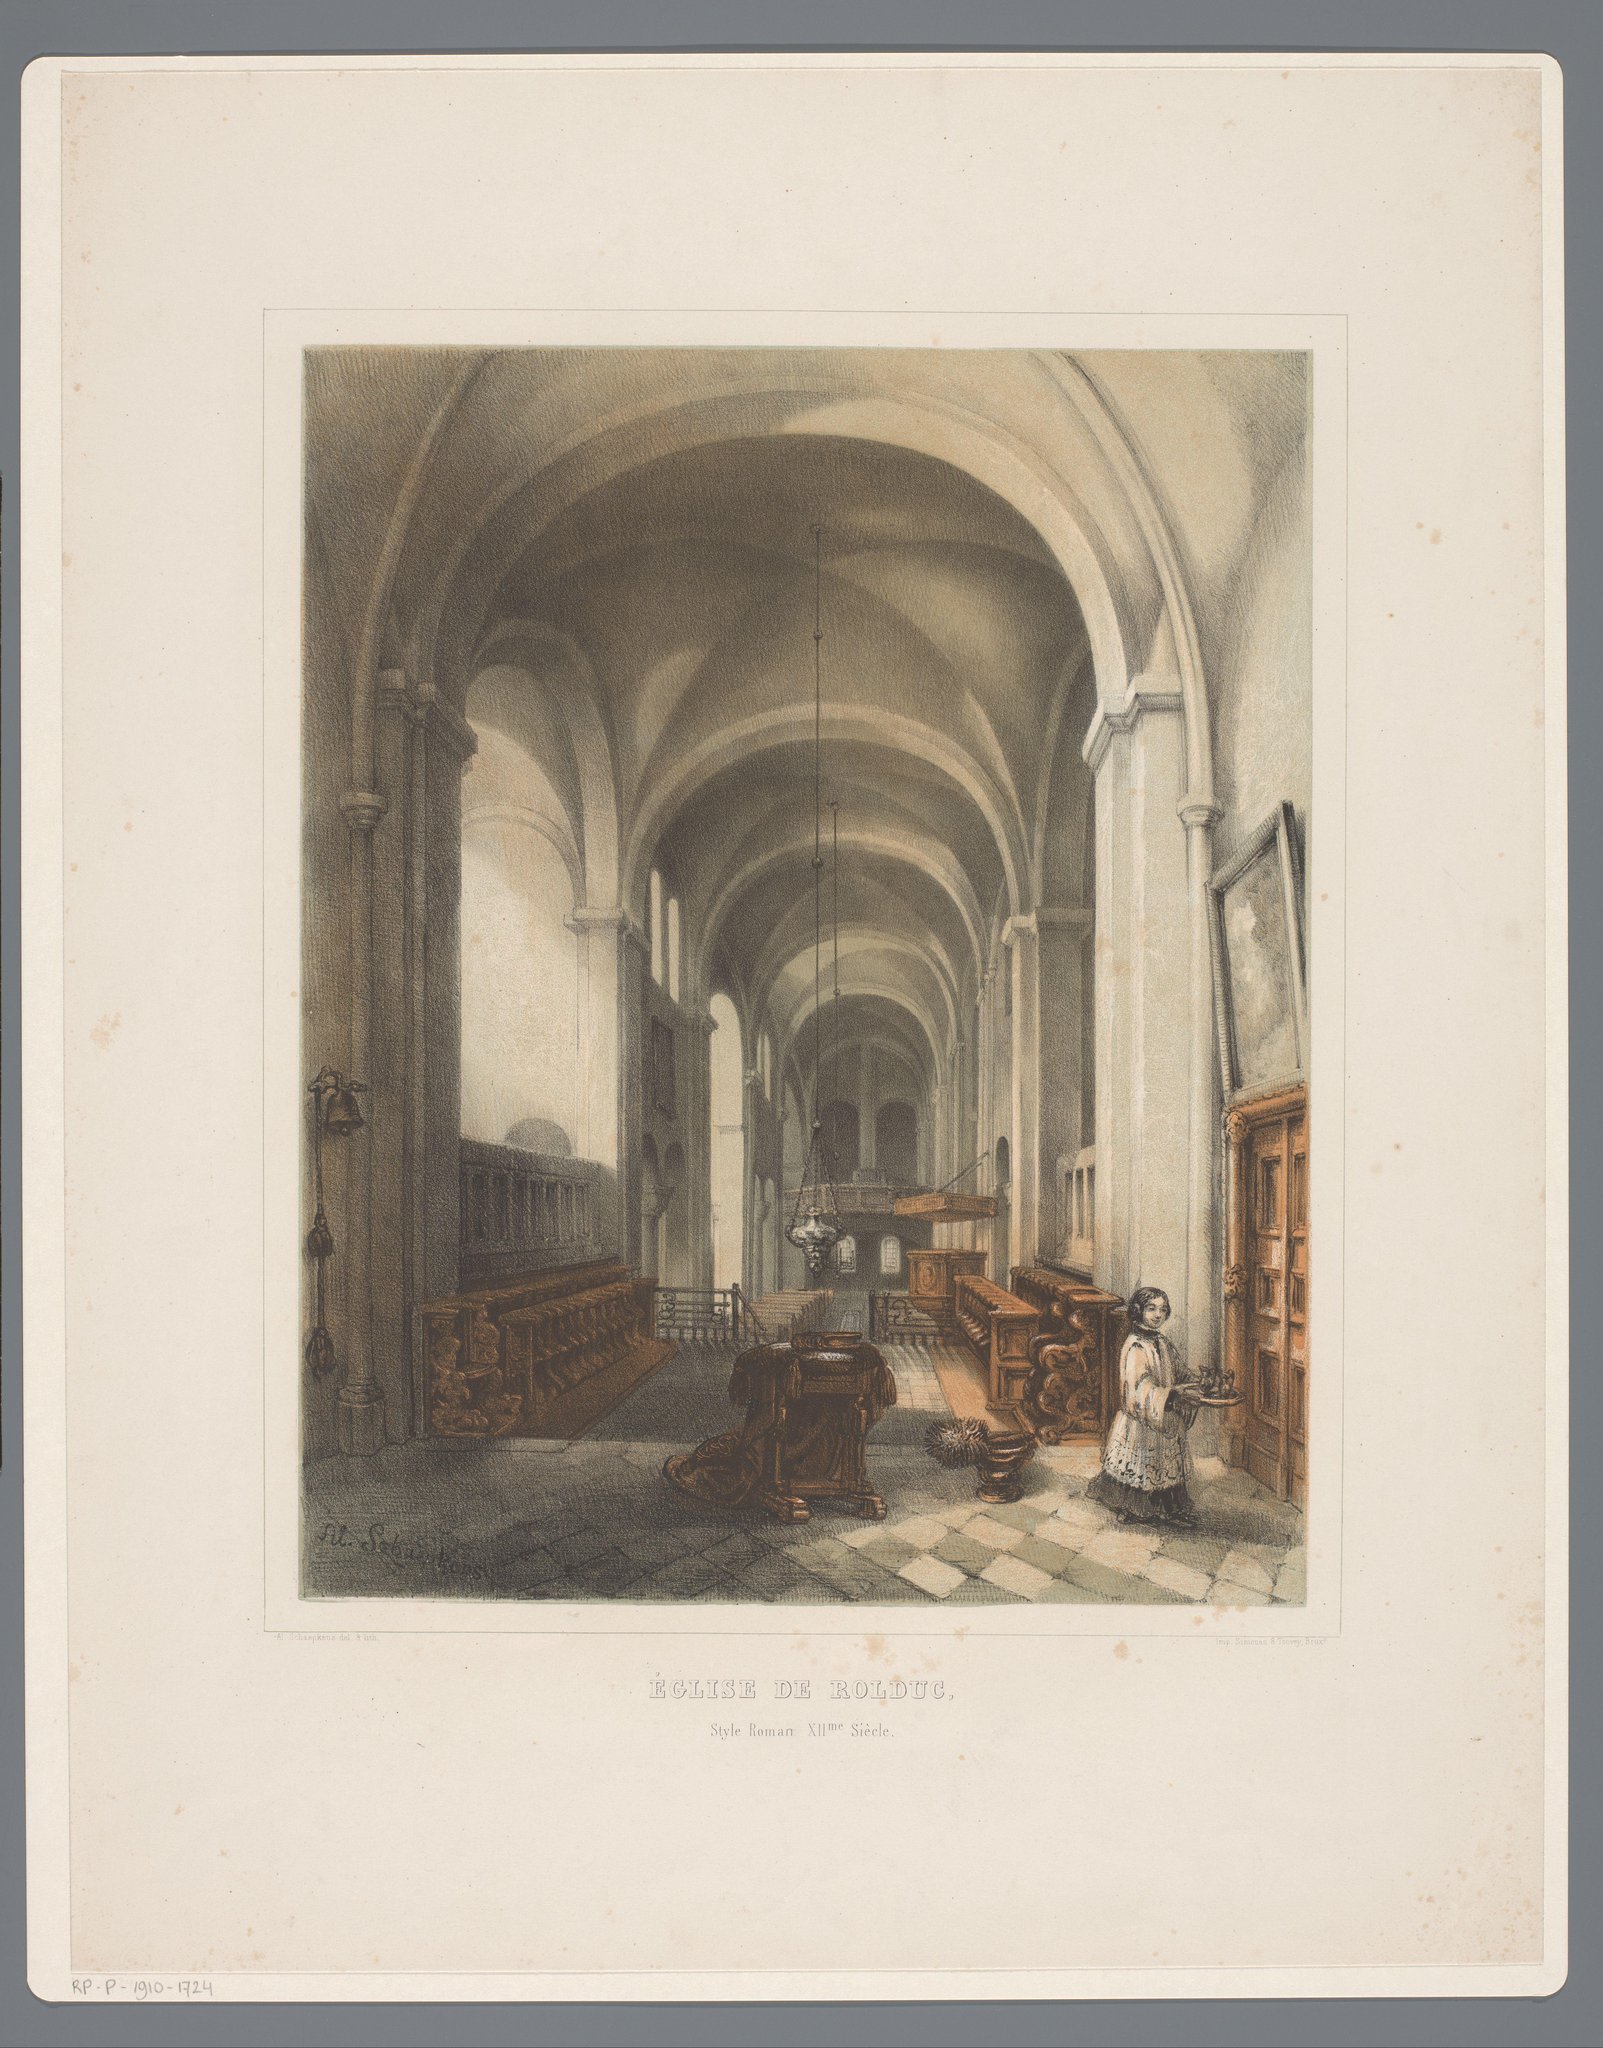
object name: print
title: Rolduc et ses environs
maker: alexander schaepkens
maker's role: draughtsman, print maker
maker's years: 1815-1899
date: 1852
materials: paper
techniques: tone lithography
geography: brussels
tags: interior of church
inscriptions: collector's mark: Lugt 2228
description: Een jongen met plateau waarop twee kannen loopt richting in deur in de abdijkerk.